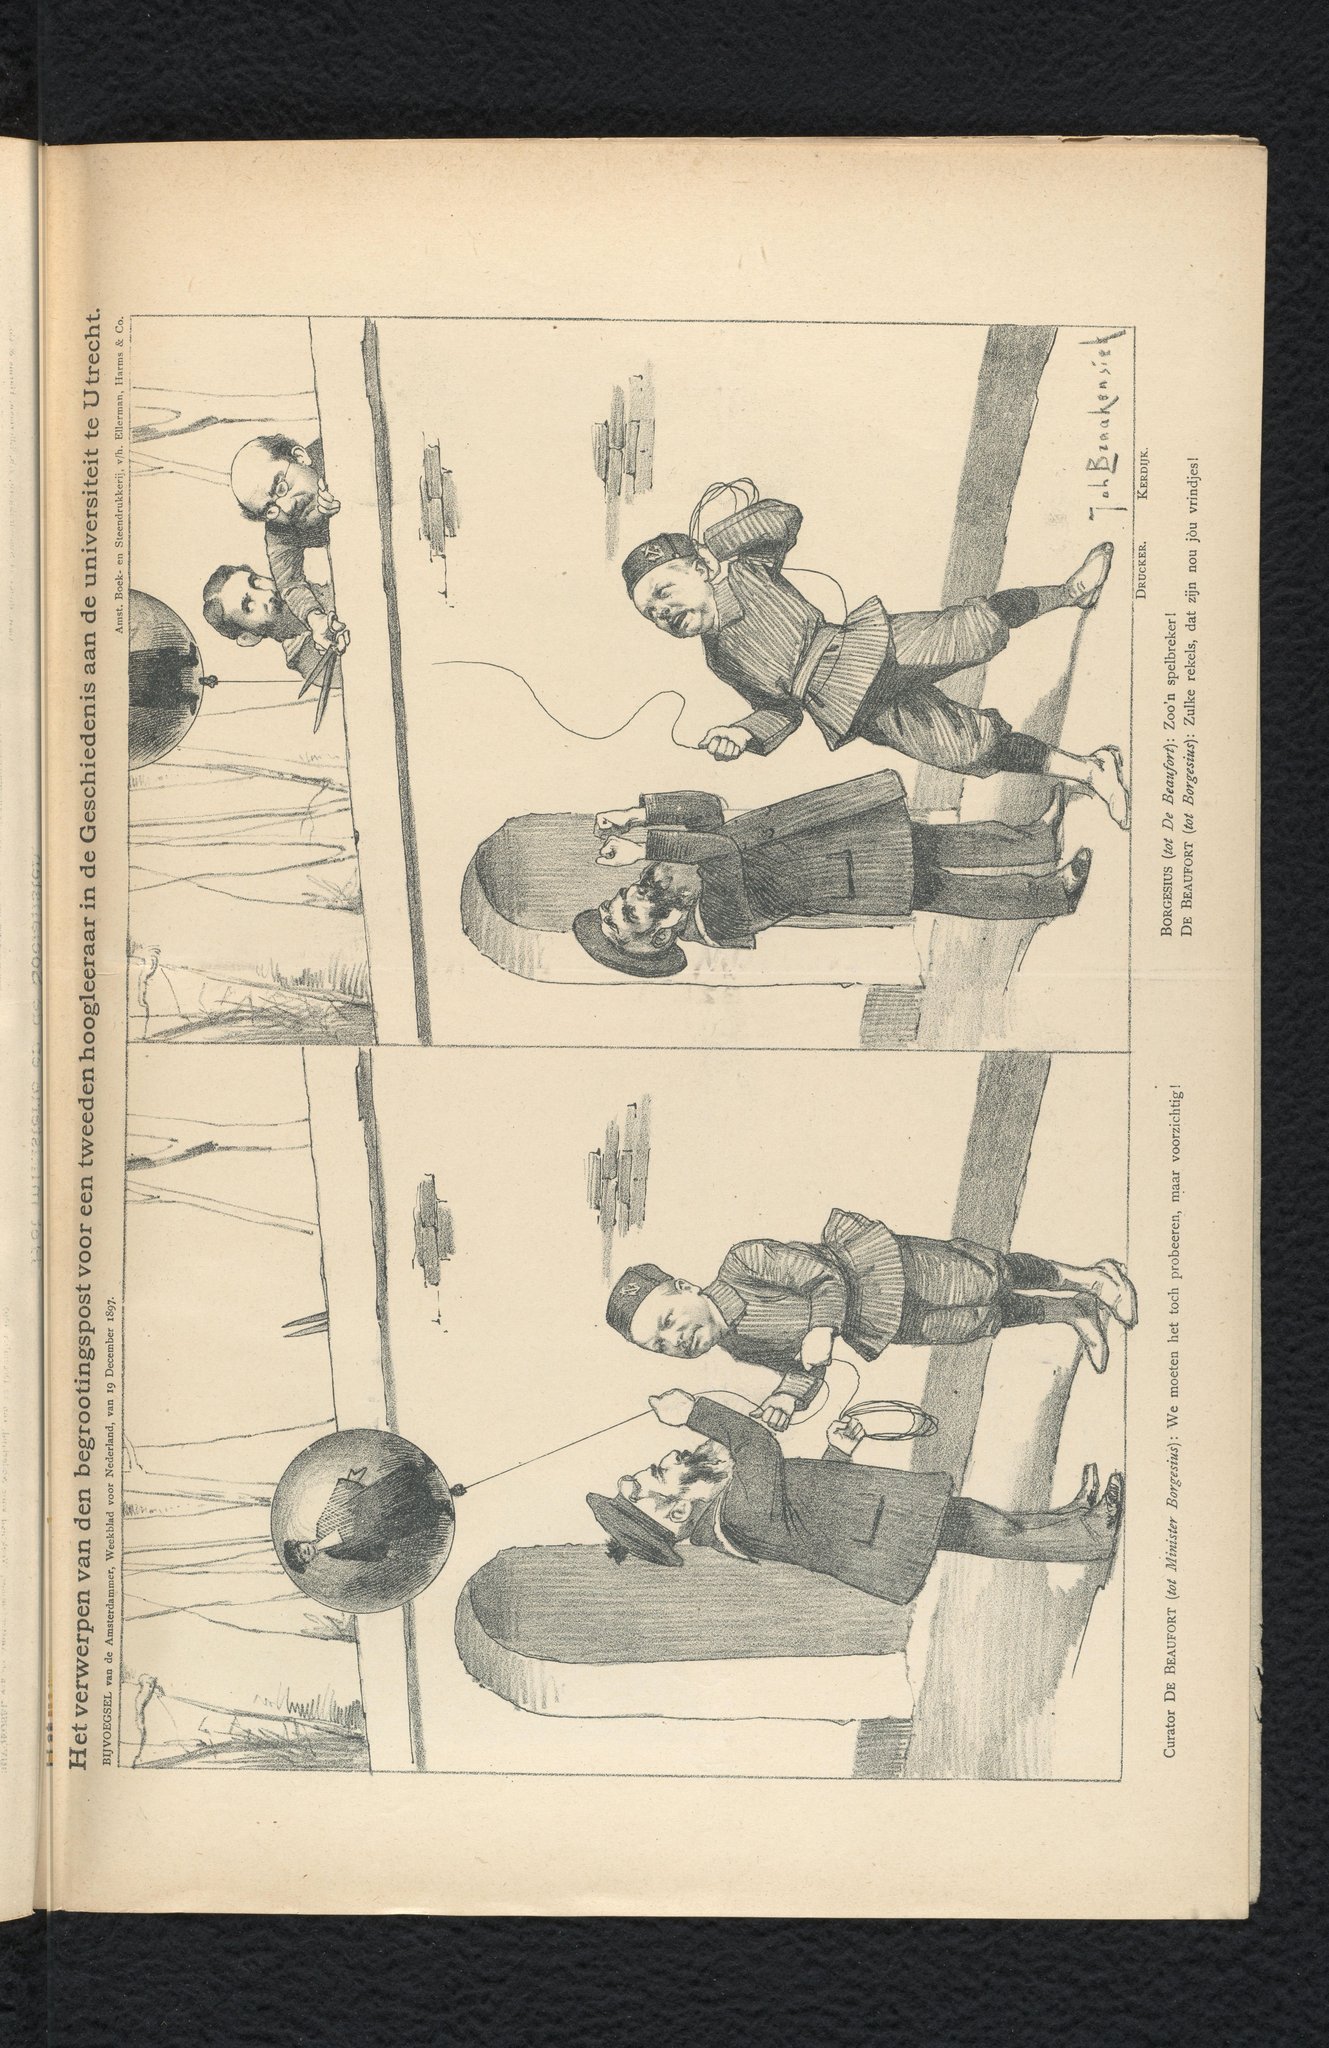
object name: cartoon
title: Het verwerpen van den begrootingspost voor een tweeden hoogleeraar in de Geschiedenis aan de universiteit te Utrecht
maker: johan braakensiek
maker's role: draughtsman, print maker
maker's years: 1858-1940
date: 1897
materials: paper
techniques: lithograph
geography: amsterdam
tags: the hague, politician, (playing with) toys, political caricatures and satires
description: Gepubliceerd als bijvoegsel bij 'De Amsterdammer' van 19 december 1897.